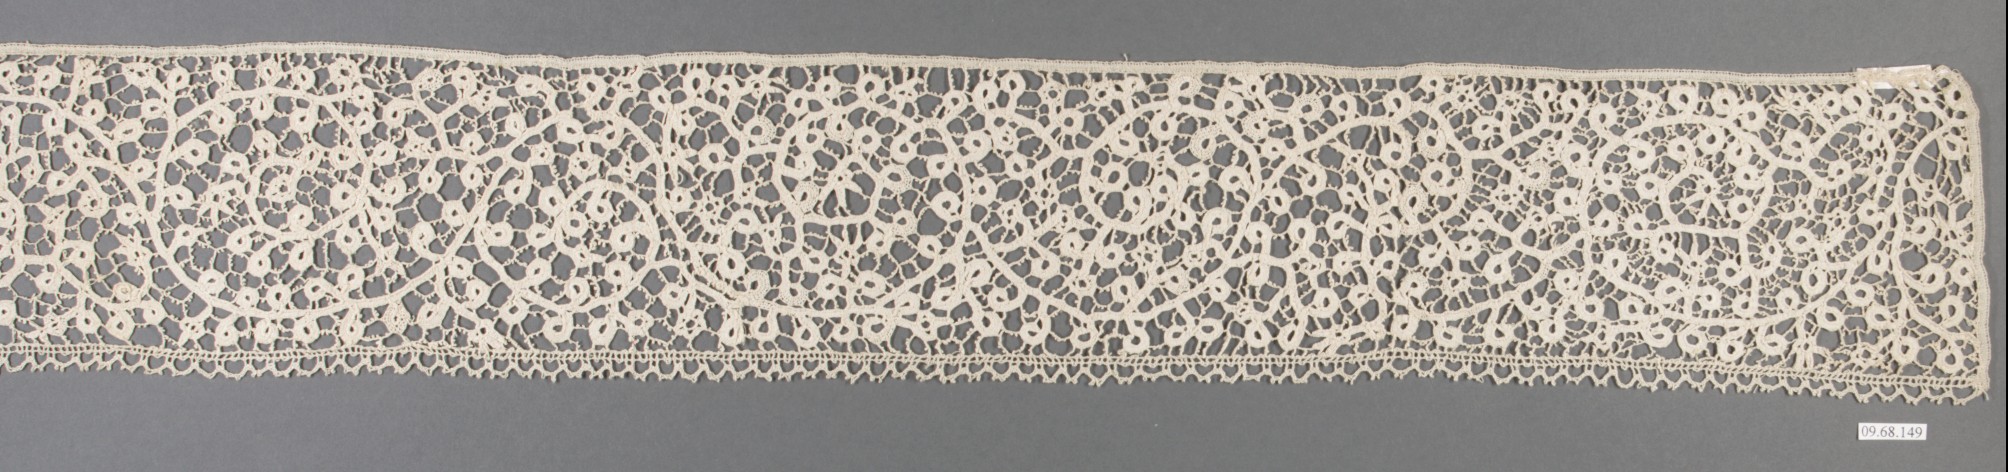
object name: fragment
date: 1601-1700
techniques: lace